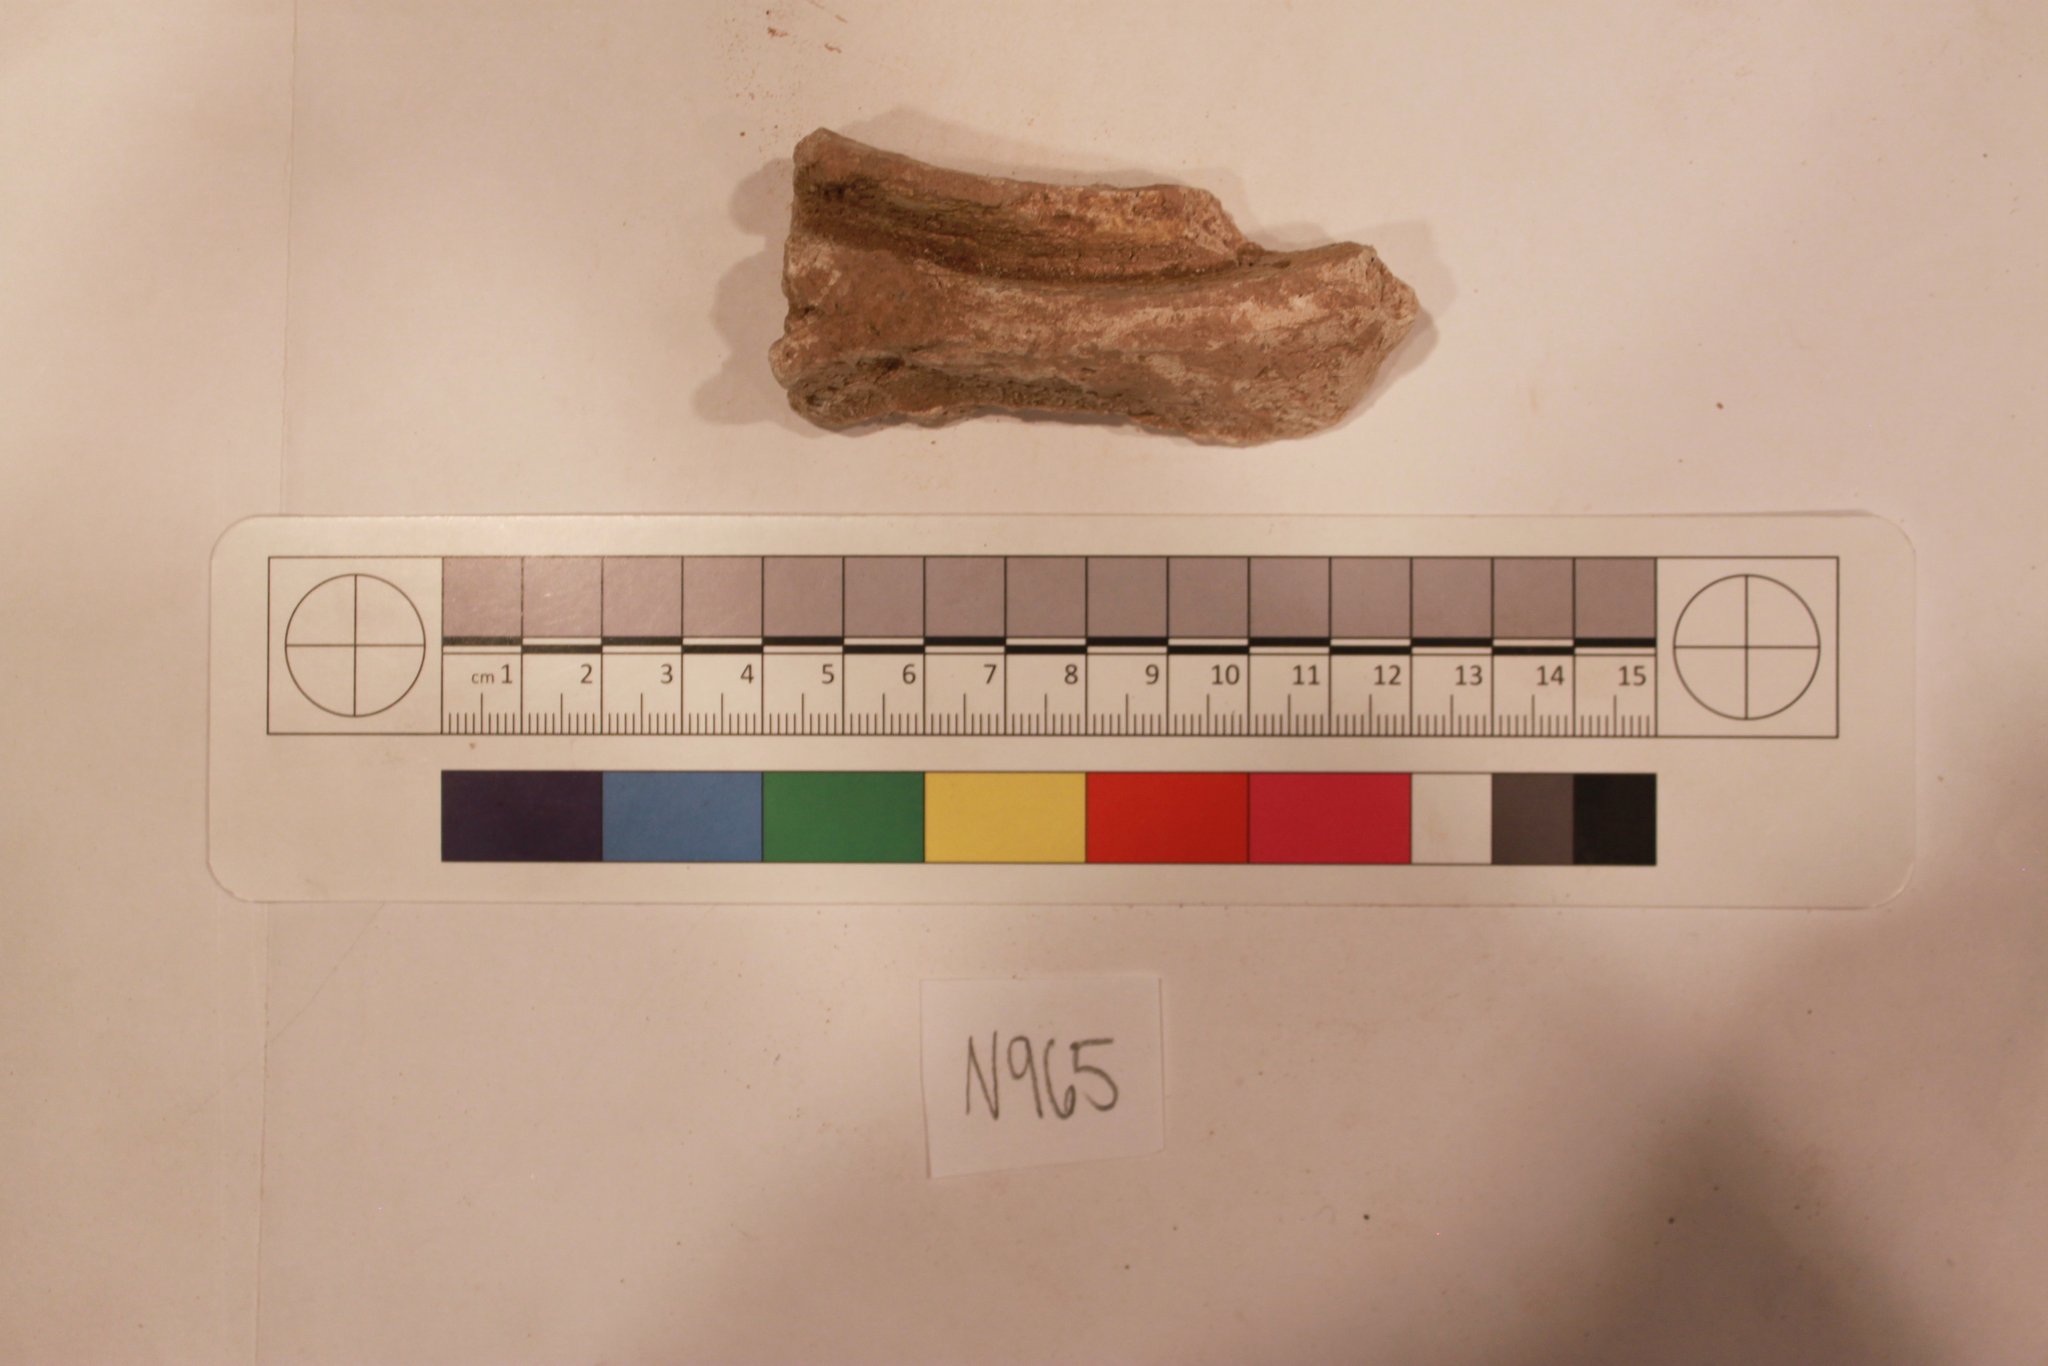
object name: fragment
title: Stucco Fragment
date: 701-1200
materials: plaster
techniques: carving, painting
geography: iran